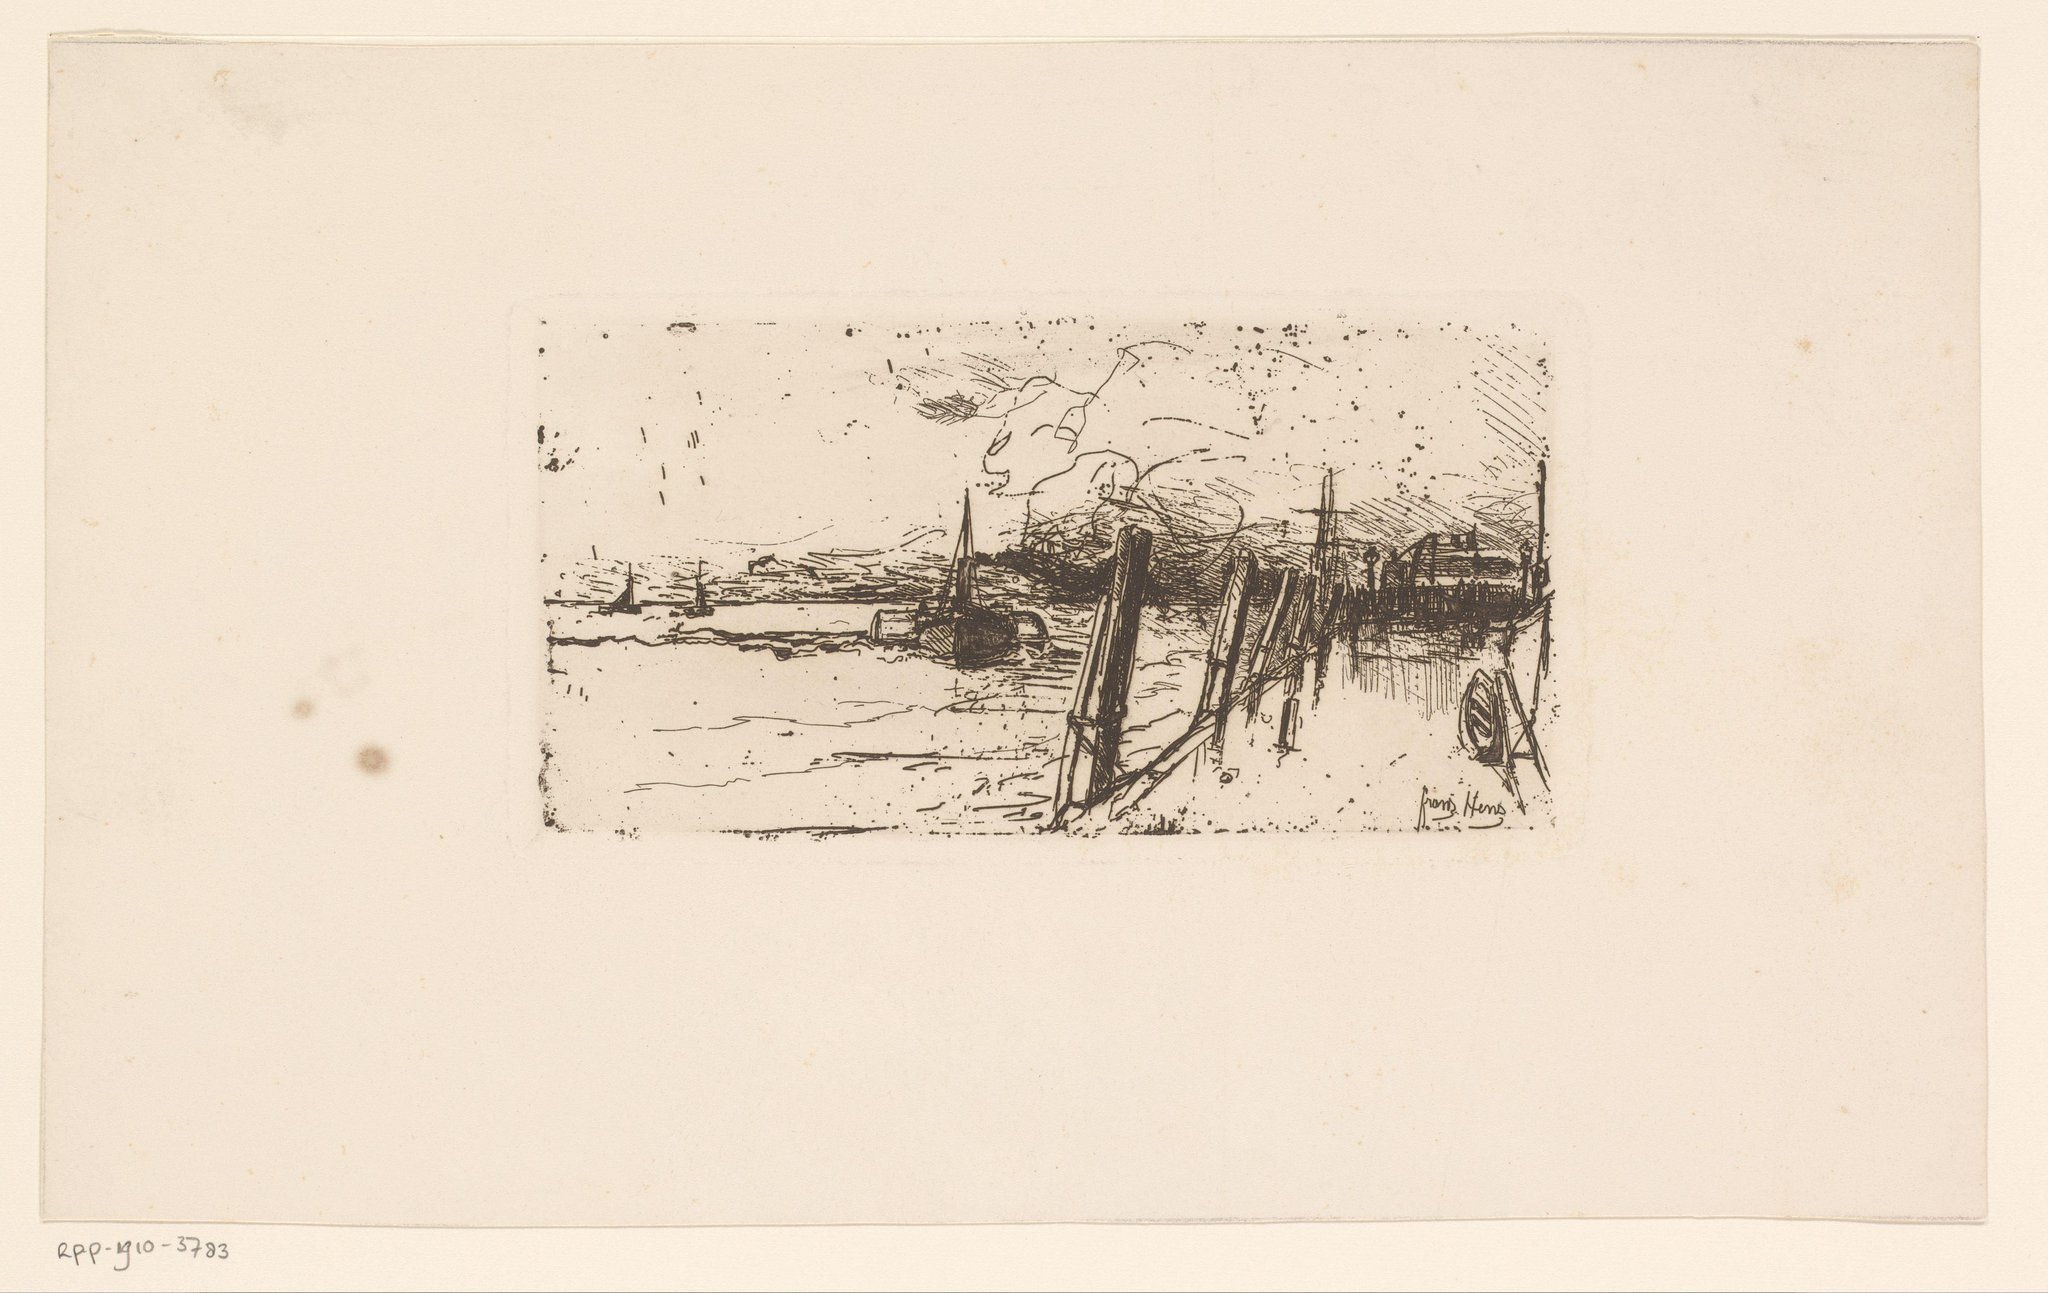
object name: print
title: Gezicht op water met boten en een kade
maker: frans hens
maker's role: print maker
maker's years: 1856-1928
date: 1884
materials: paper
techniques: etching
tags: pier, quay, wharf, traffic on the water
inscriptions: collector's mark: Lugt 2228